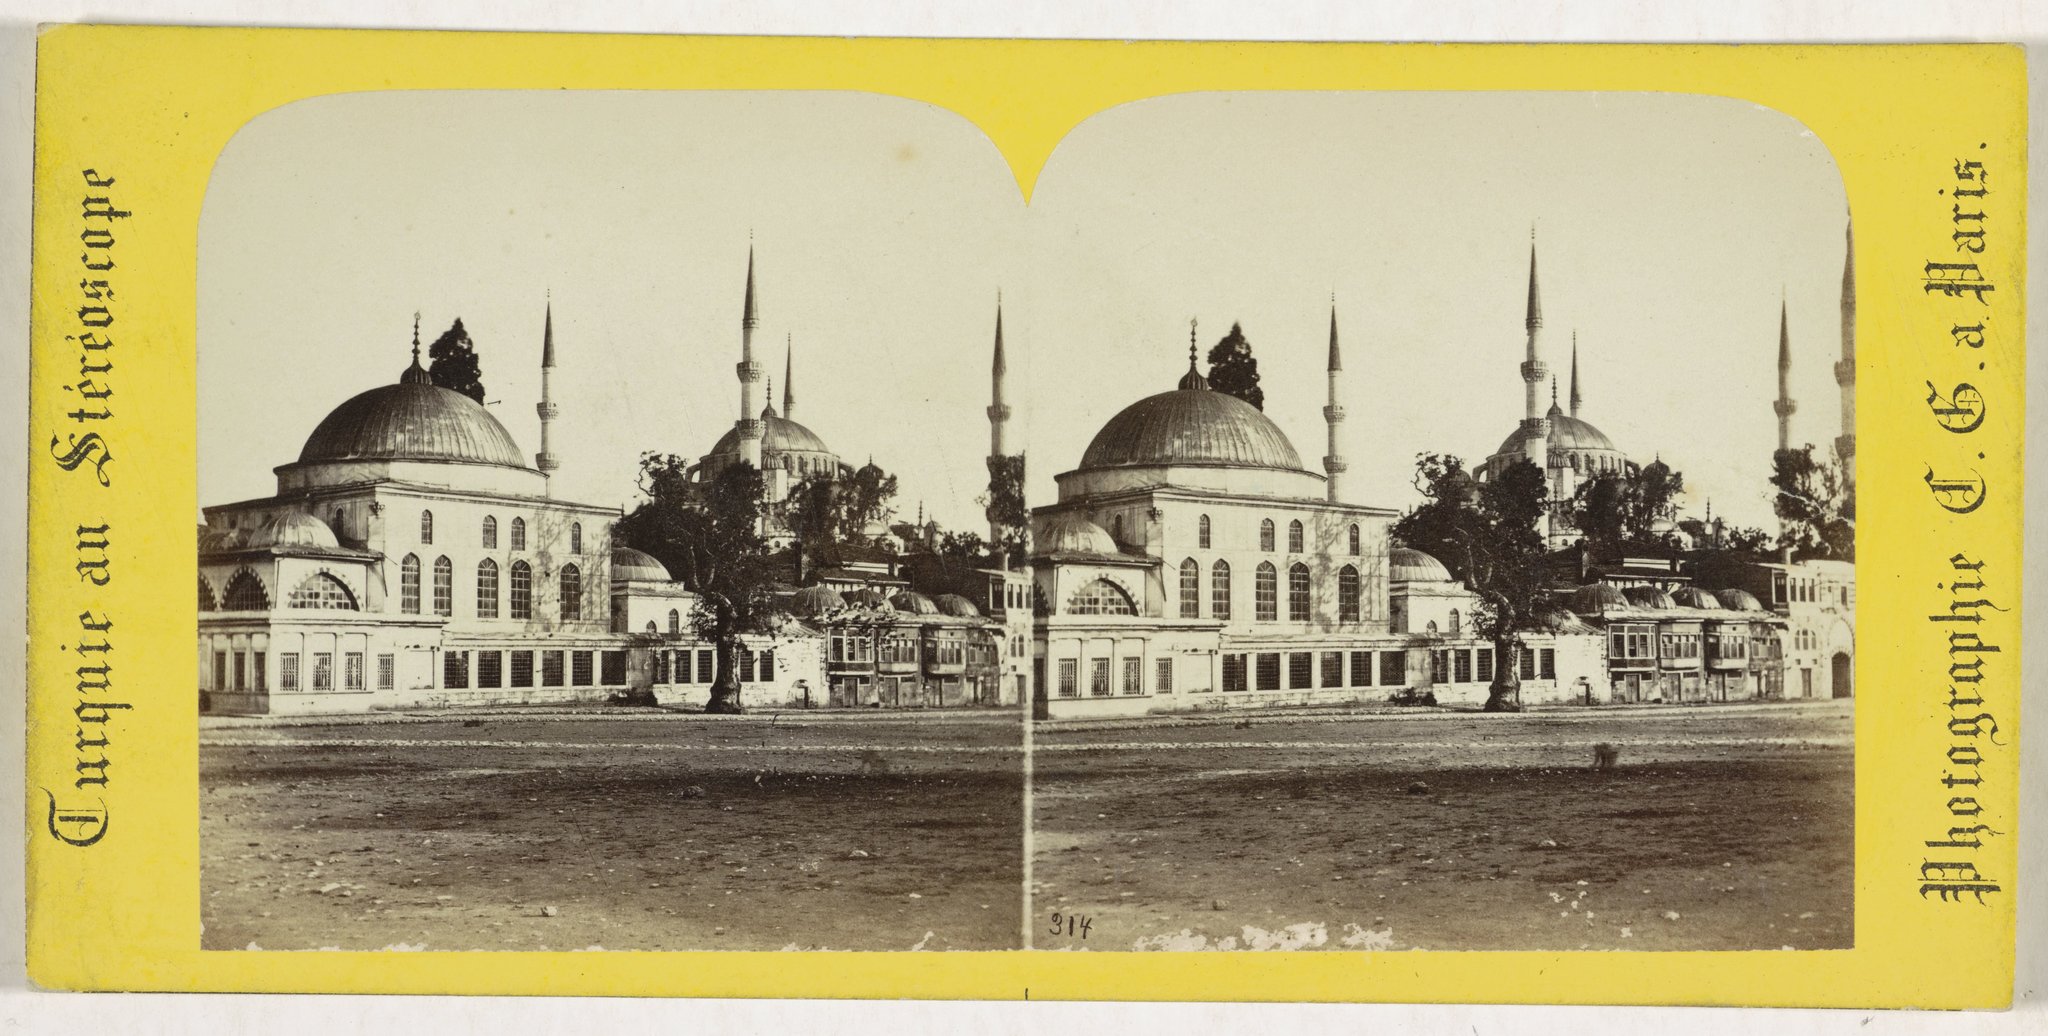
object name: stereograph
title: Sultan Ahmetmoskee, Istanboel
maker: charles gaudin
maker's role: publisher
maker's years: 1825-1905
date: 1861-1870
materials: cardboard, paper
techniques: albumen print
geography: sultan ahmetmoskee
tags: temple, shrine ~ islam, mohammedanism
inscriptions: number: ‘314’